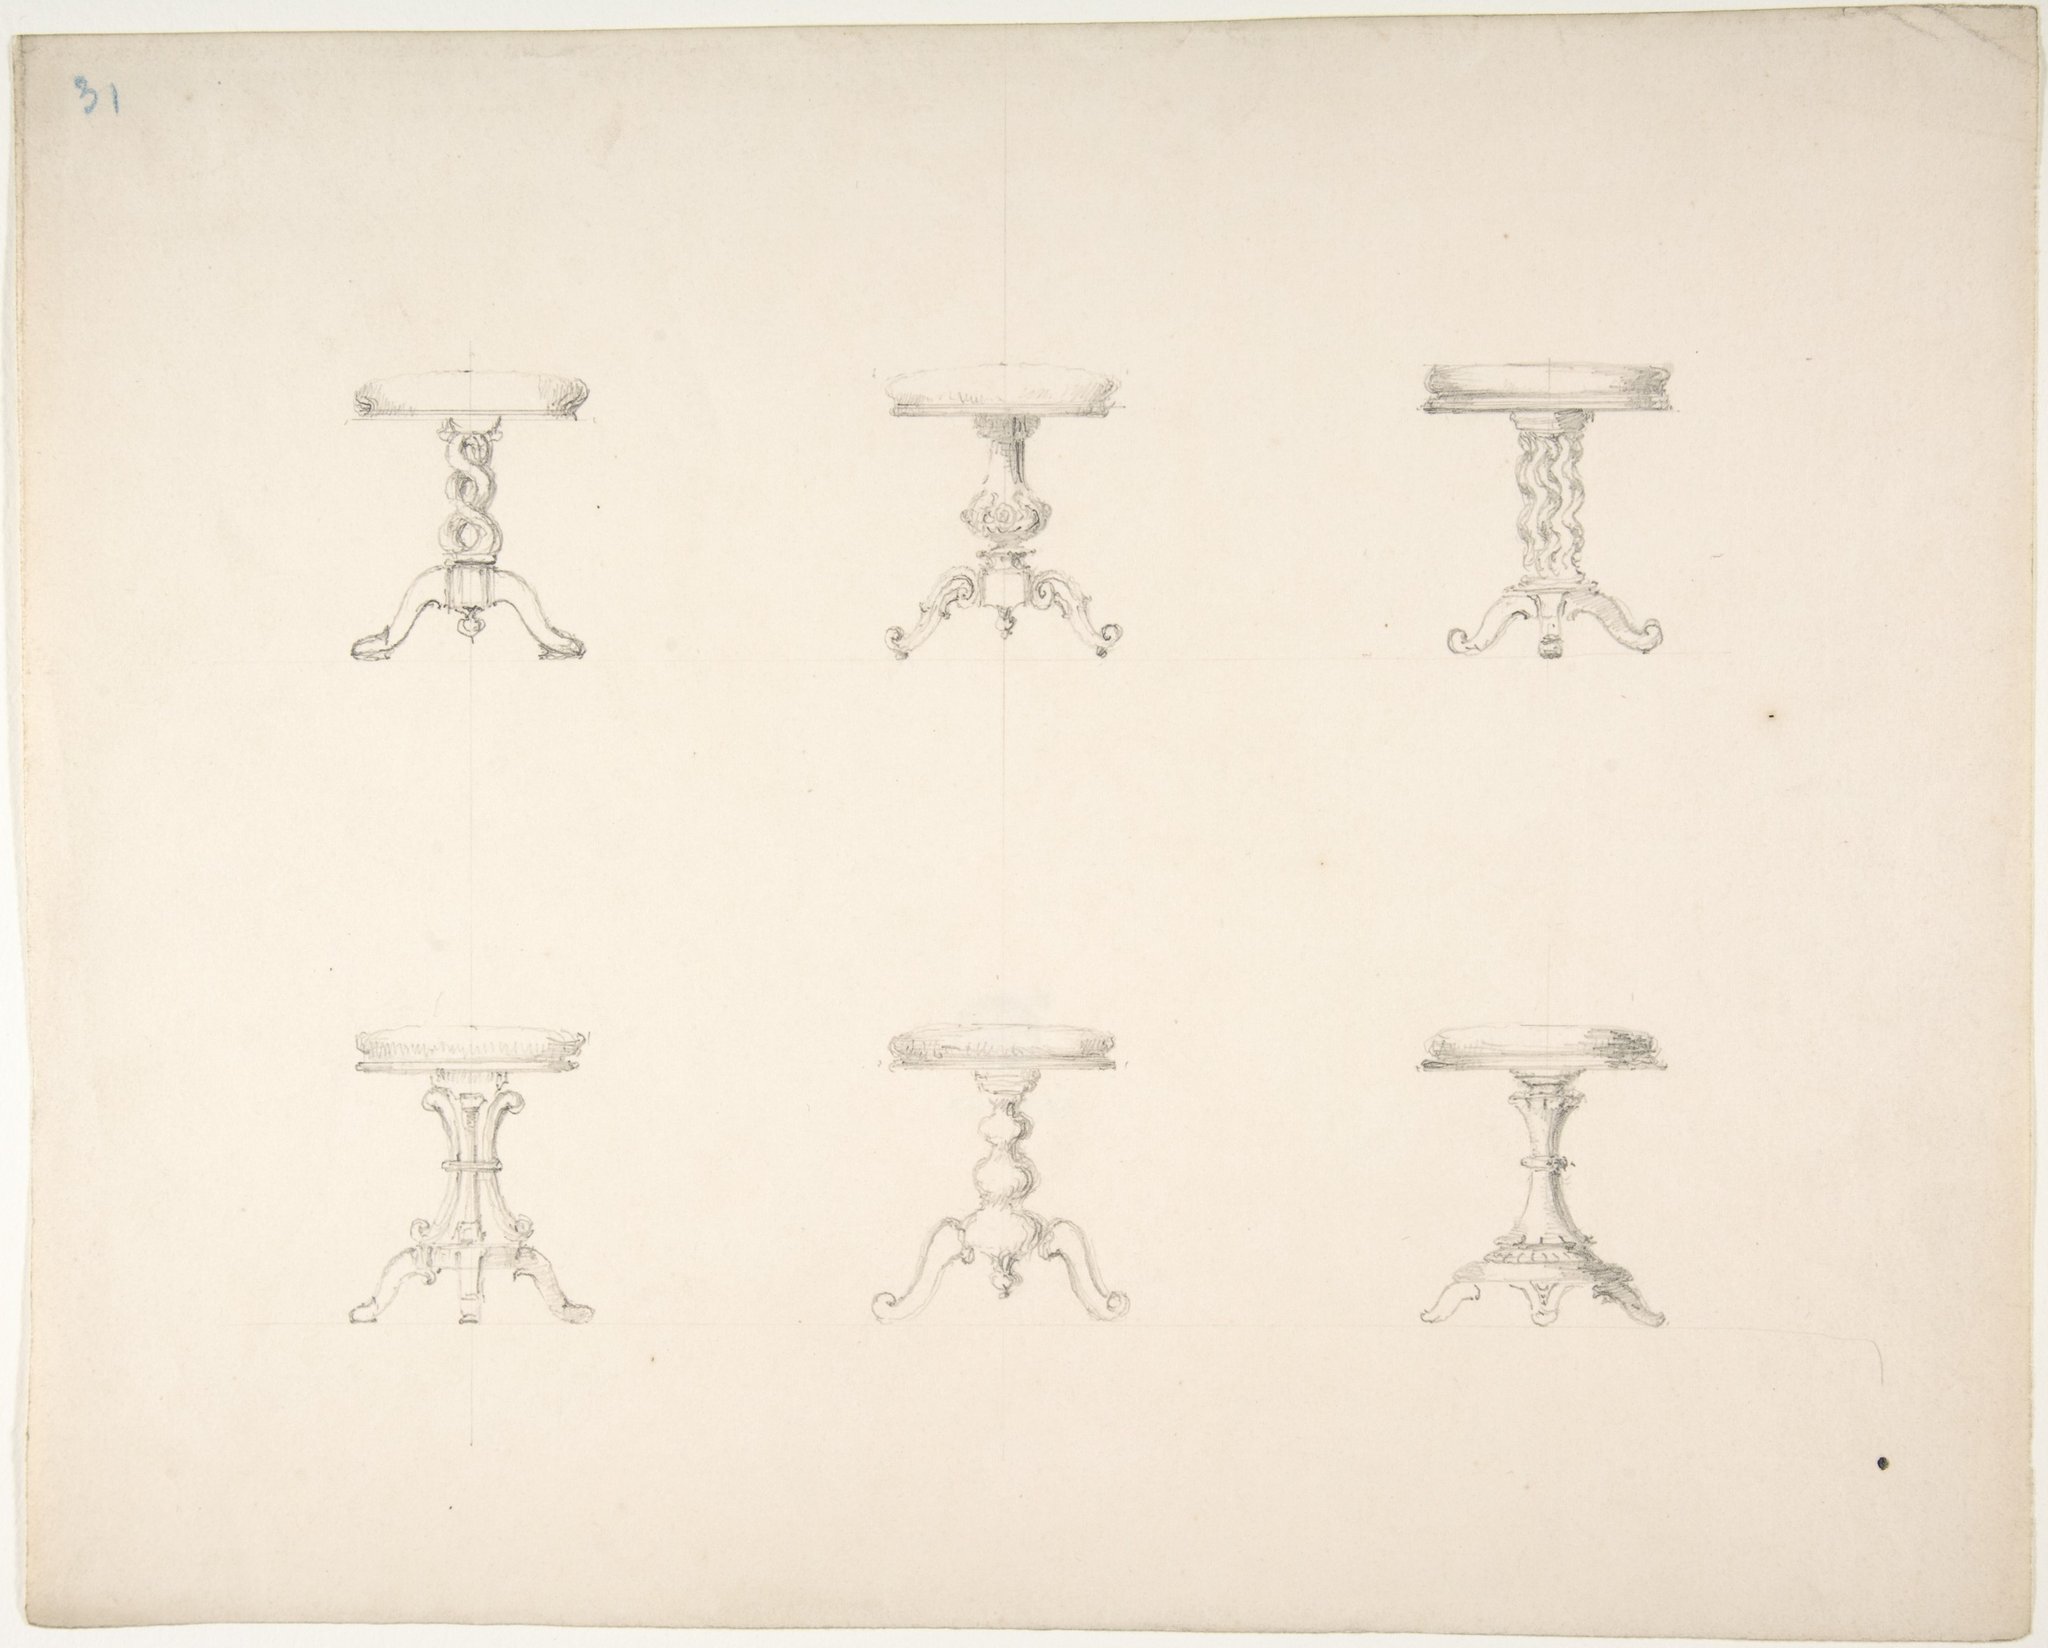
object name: drawing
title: Design for Six Tripod Tables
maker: anonymous, british, 19th century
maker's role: artist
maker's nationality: british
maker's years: 1800-1900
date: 1801-1833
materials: graphite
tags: tables